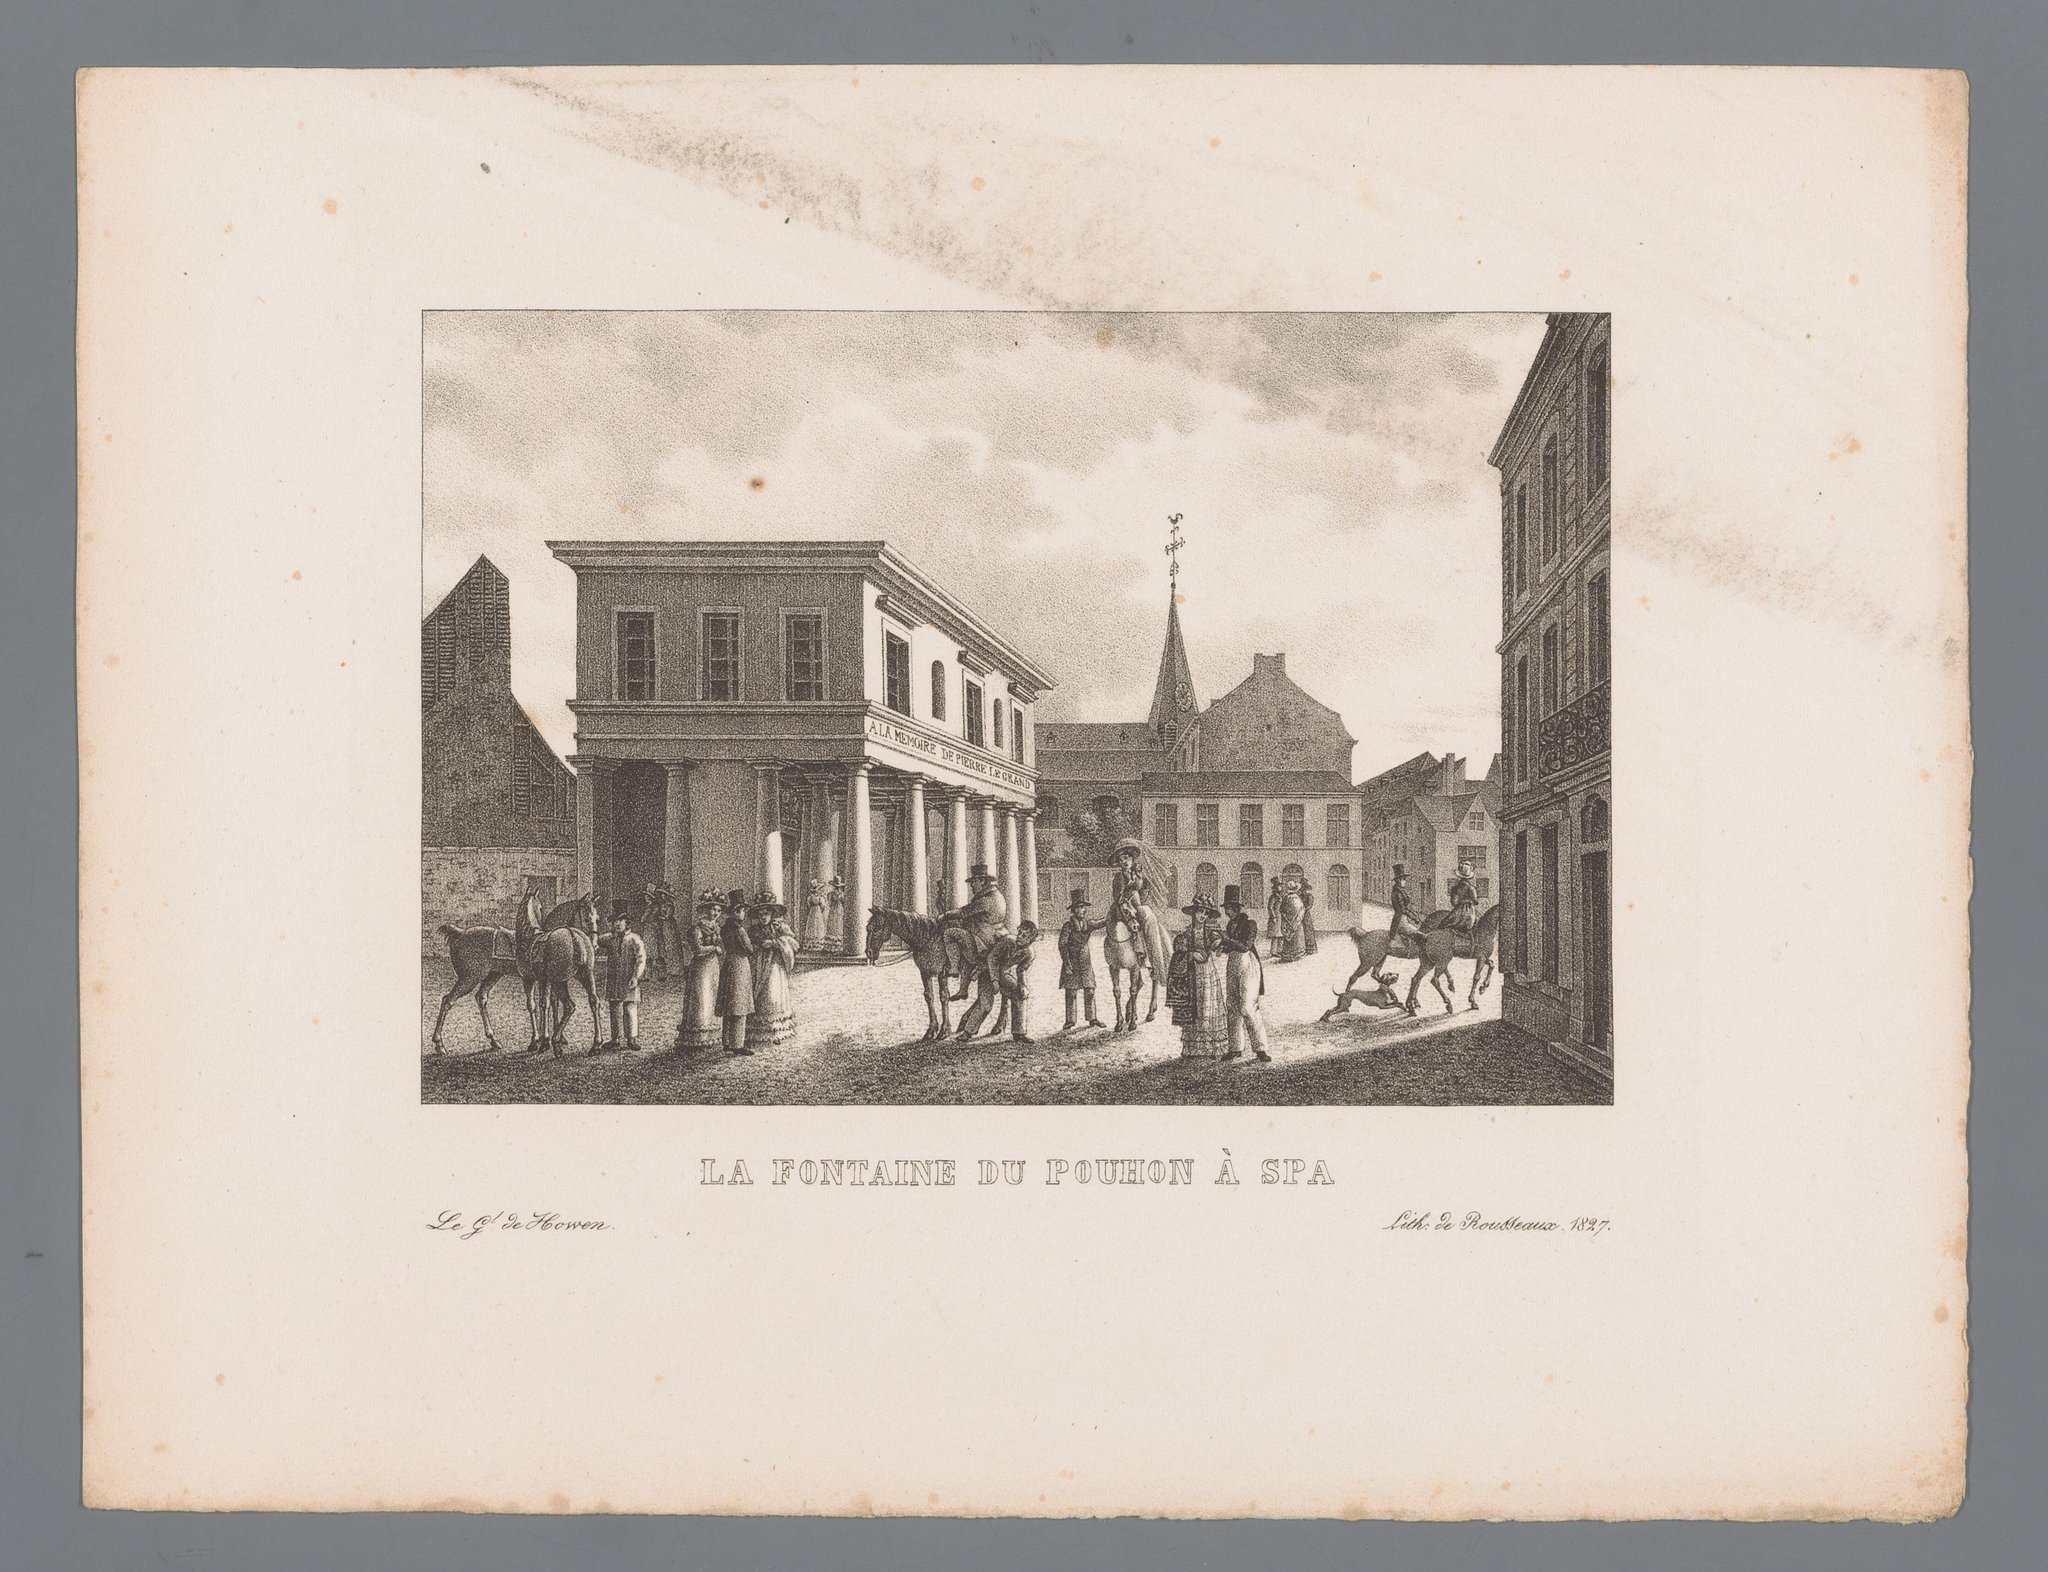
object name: print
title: Gezicht op de bron Pouhon Pia in Spa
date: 1827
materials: paper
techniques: lithograph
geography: namur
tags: mineral water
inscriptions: collector's mark: Lugt 2228